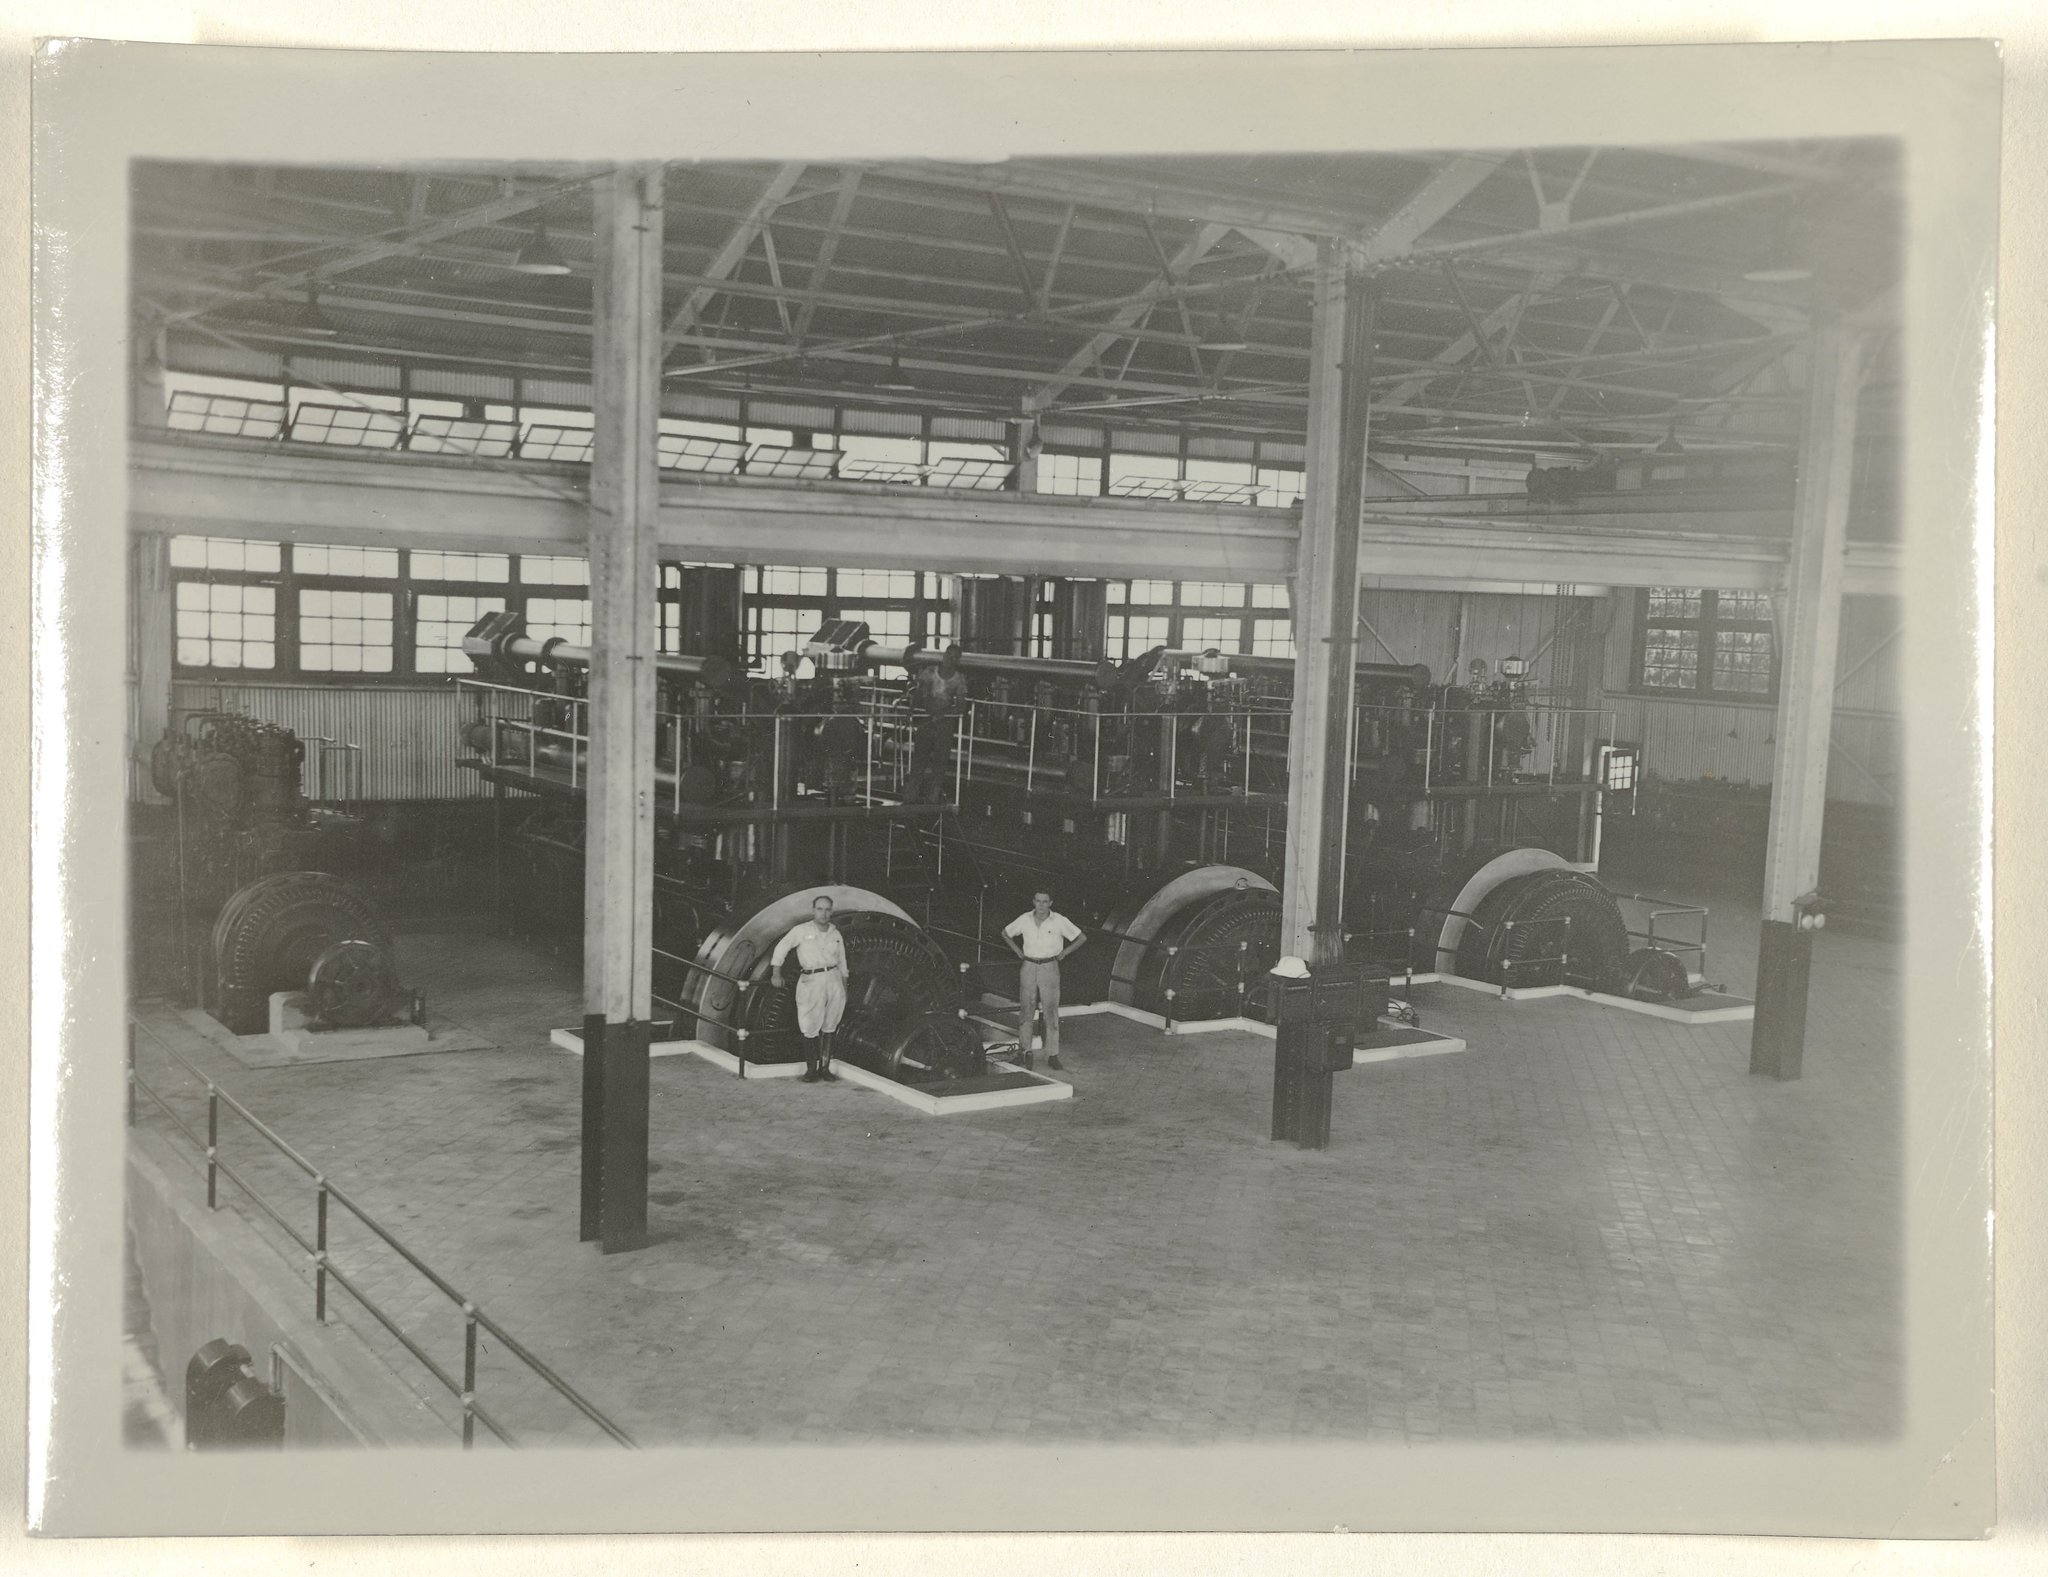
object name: photograph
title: Turbines in de bauxietfabriek in Moengo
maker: Anonymous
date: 1929-1930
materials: photographic support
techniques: photography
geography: suriname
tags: factory-interior, machine shop